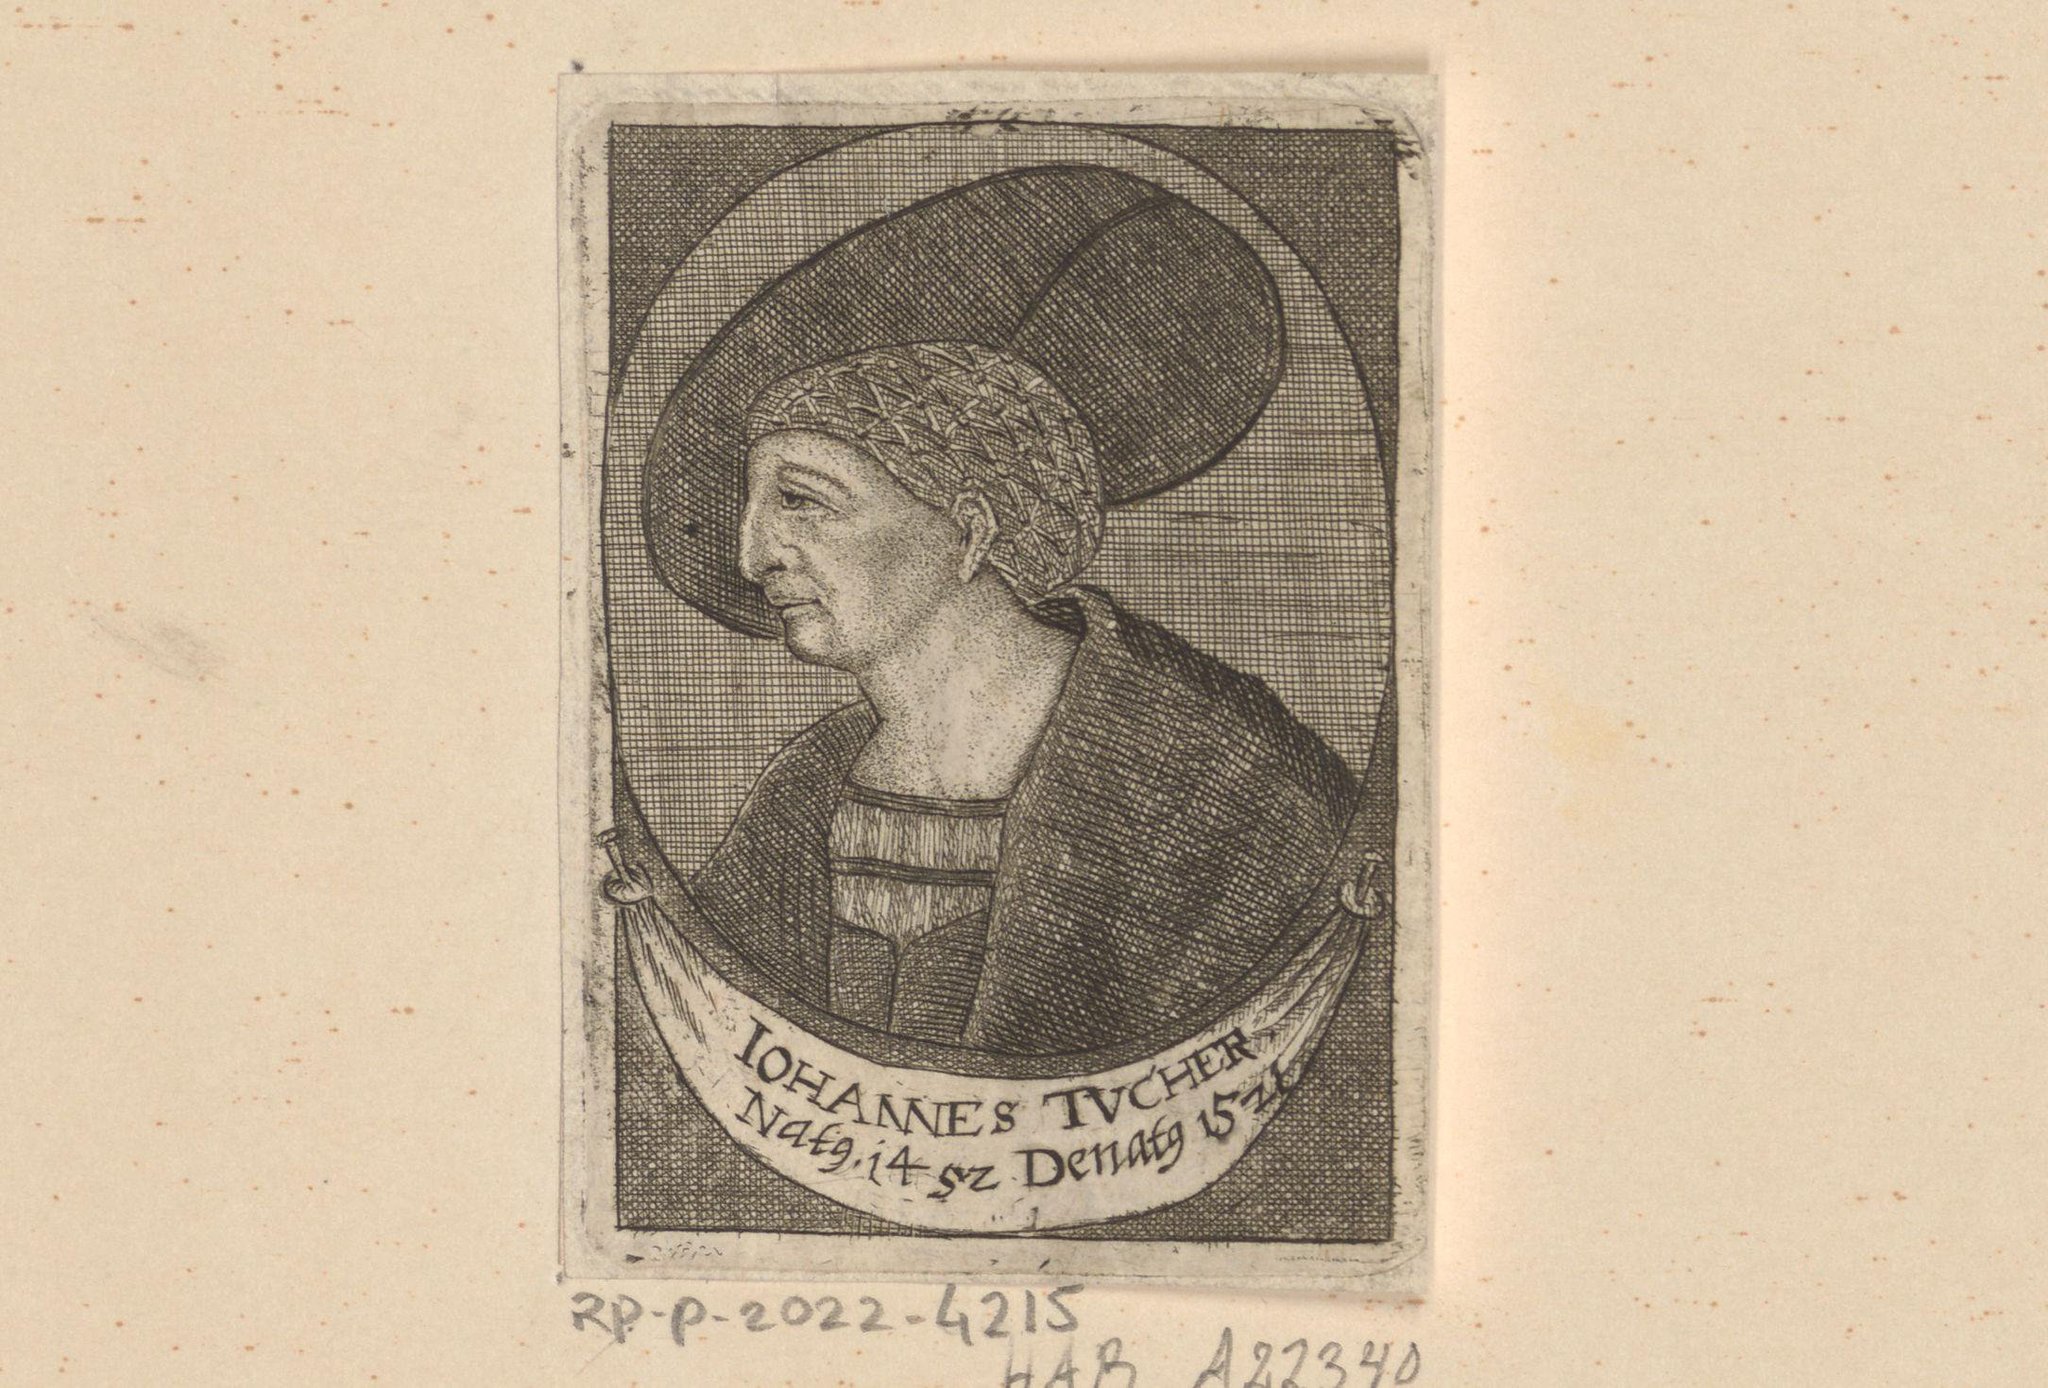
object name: print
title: Portret van Johan Tucher (III)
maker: Anonymous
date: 1600-1699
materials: paper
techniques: etching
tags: historical persons